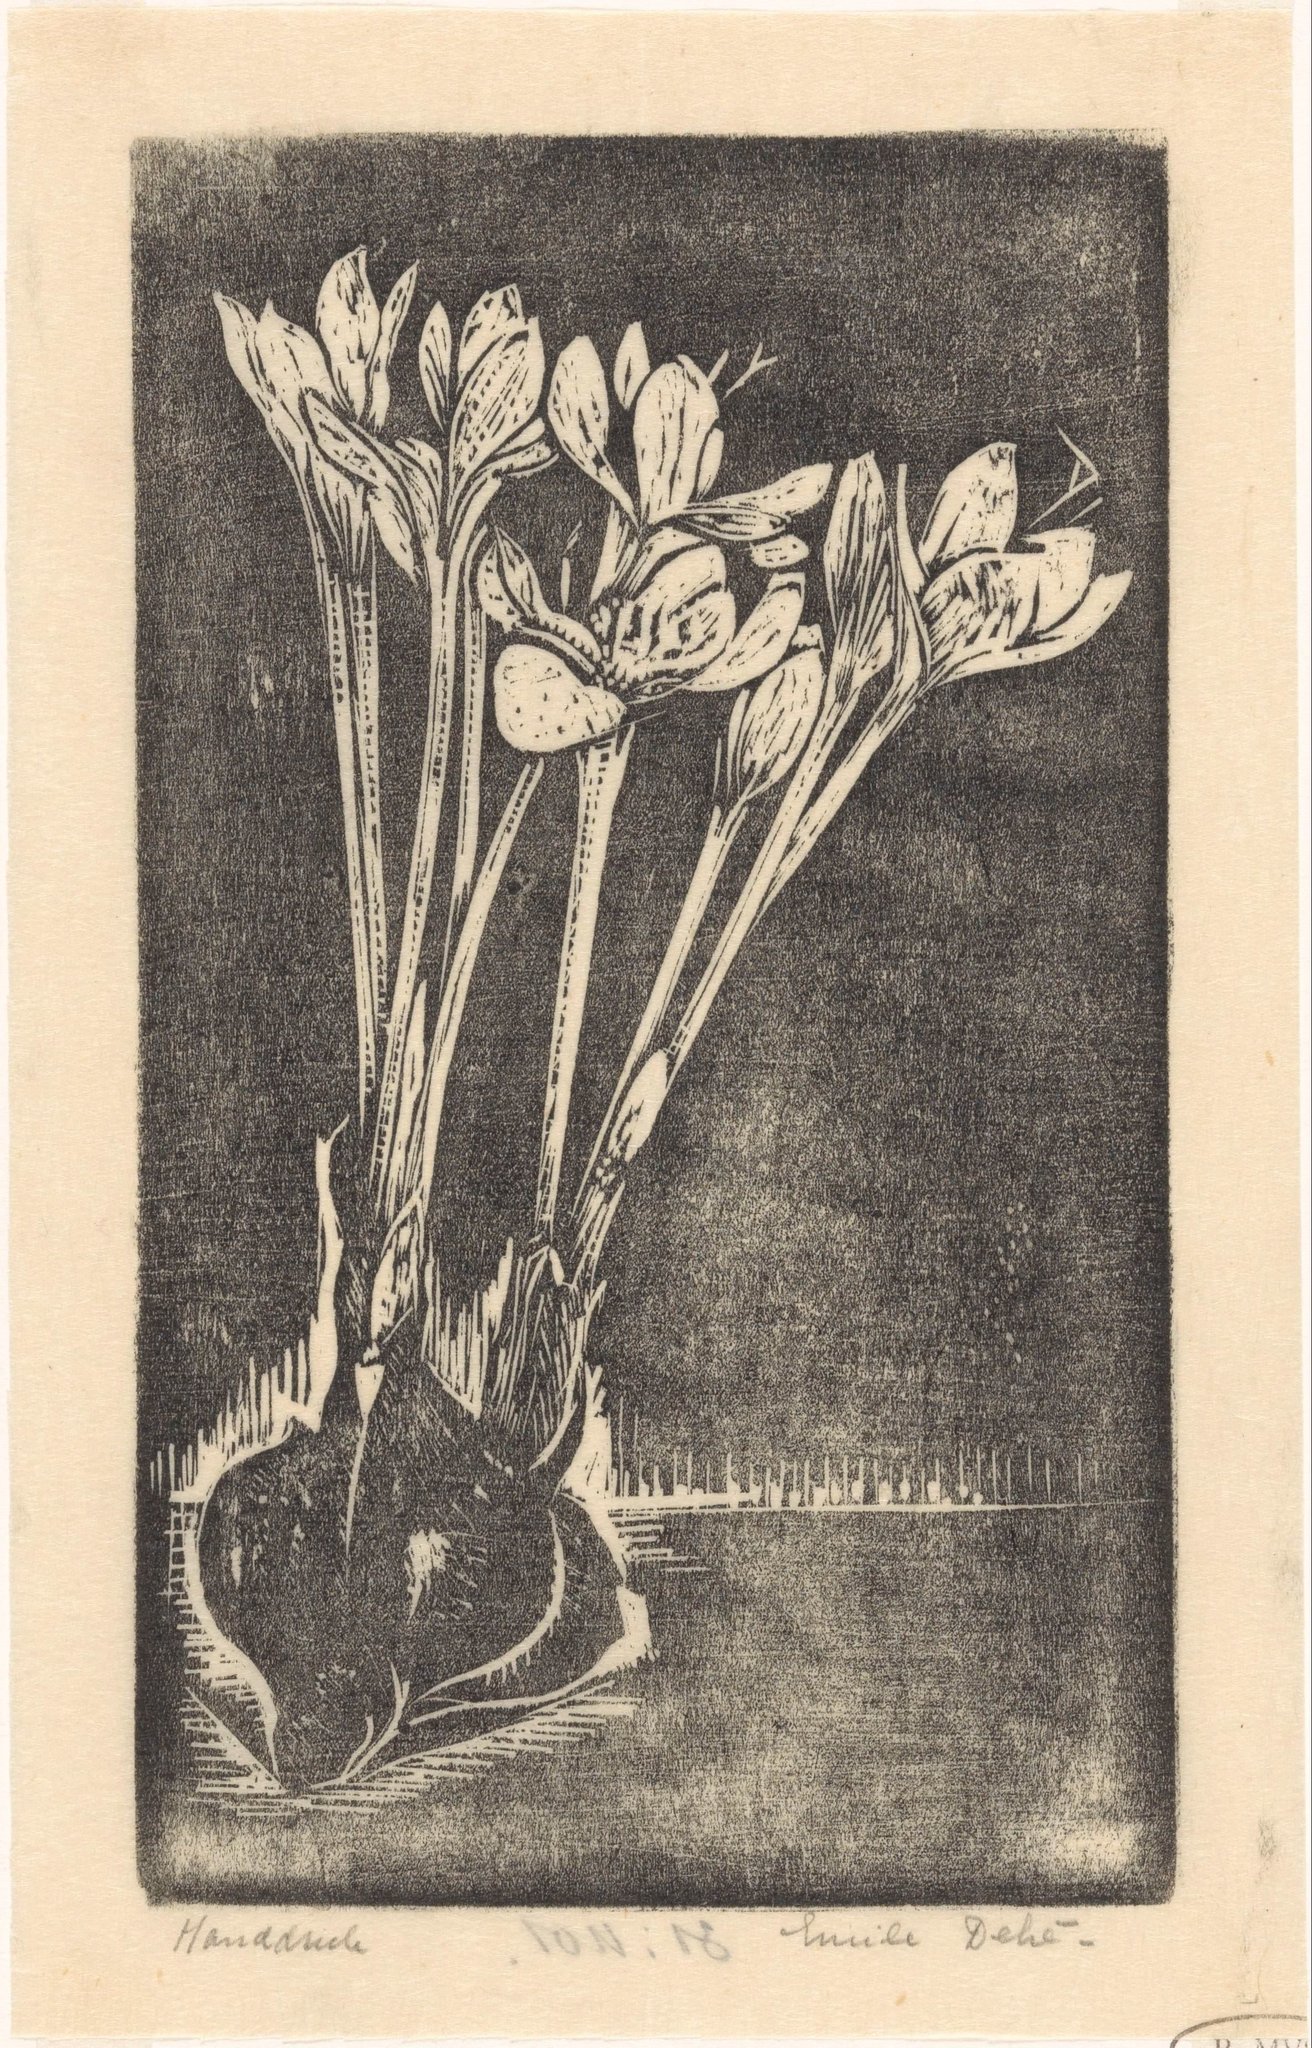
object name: print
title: Herfsttijloos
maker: emilius wilhelmus dehé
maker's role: draughtsman, print maker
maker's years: 1886-1947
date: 1896-1931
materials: paper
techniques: woodcut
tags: flowers (+ bulb)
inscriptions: collector's mark: Lugt 2228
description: Bloeiende bloembollen, liggend op een oppervlak.